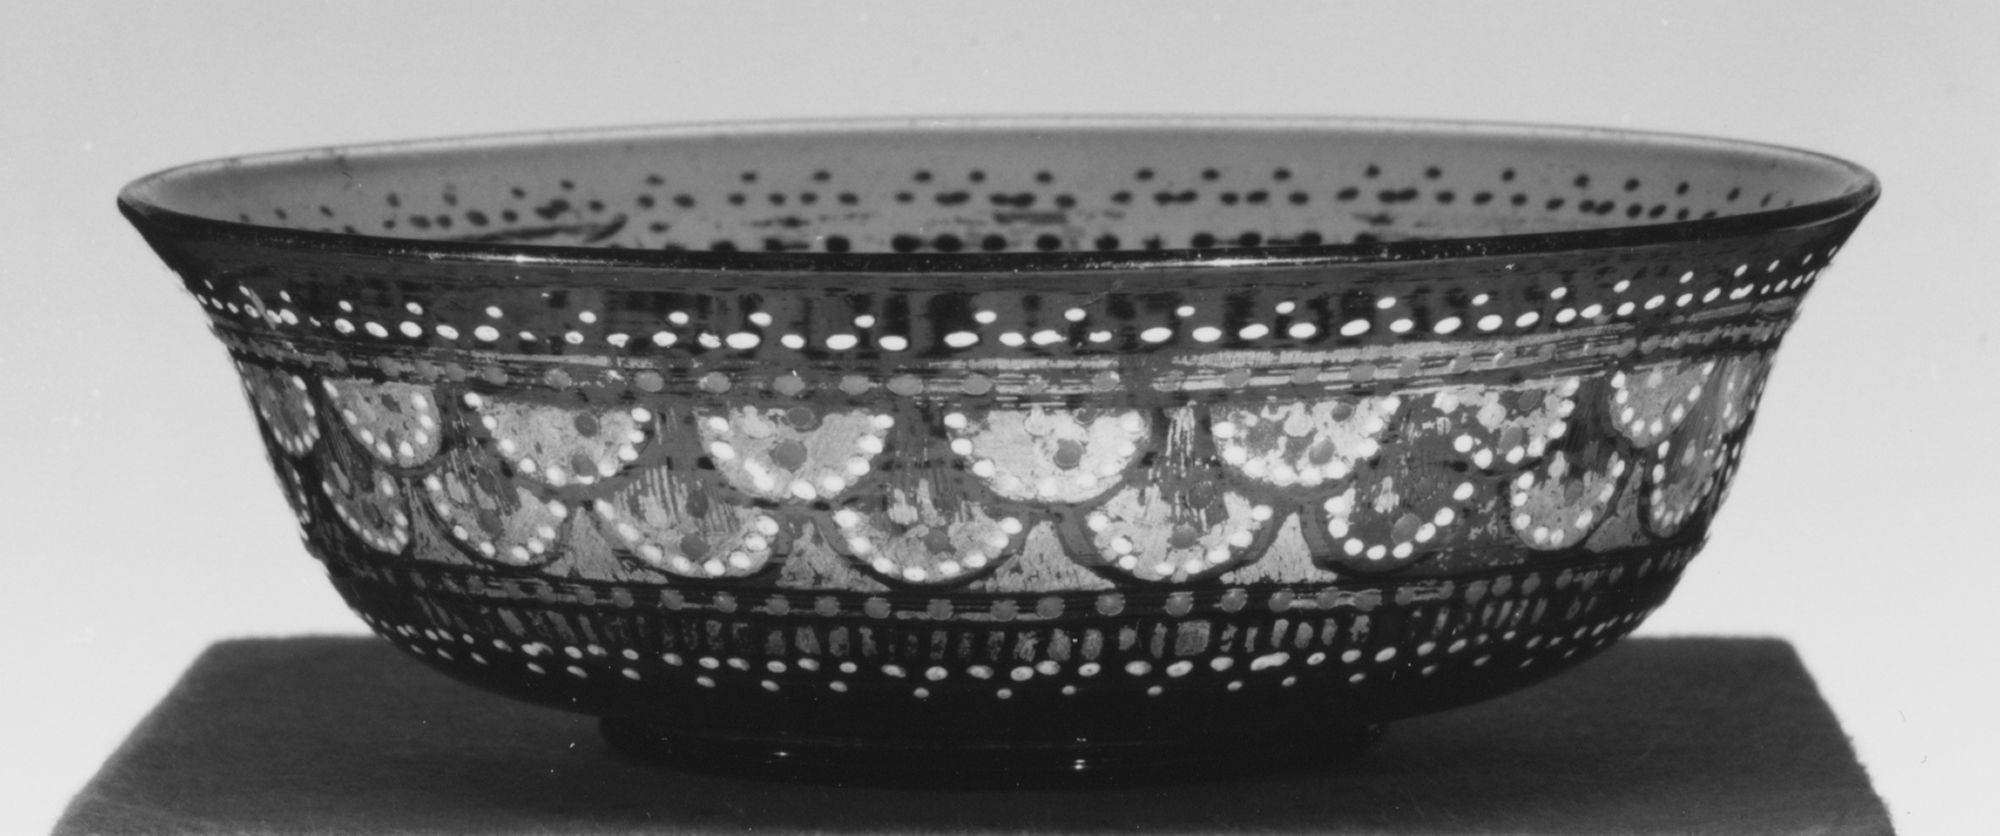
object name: bowl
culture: italian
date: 1500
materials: gilt, glass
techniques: glassblowing